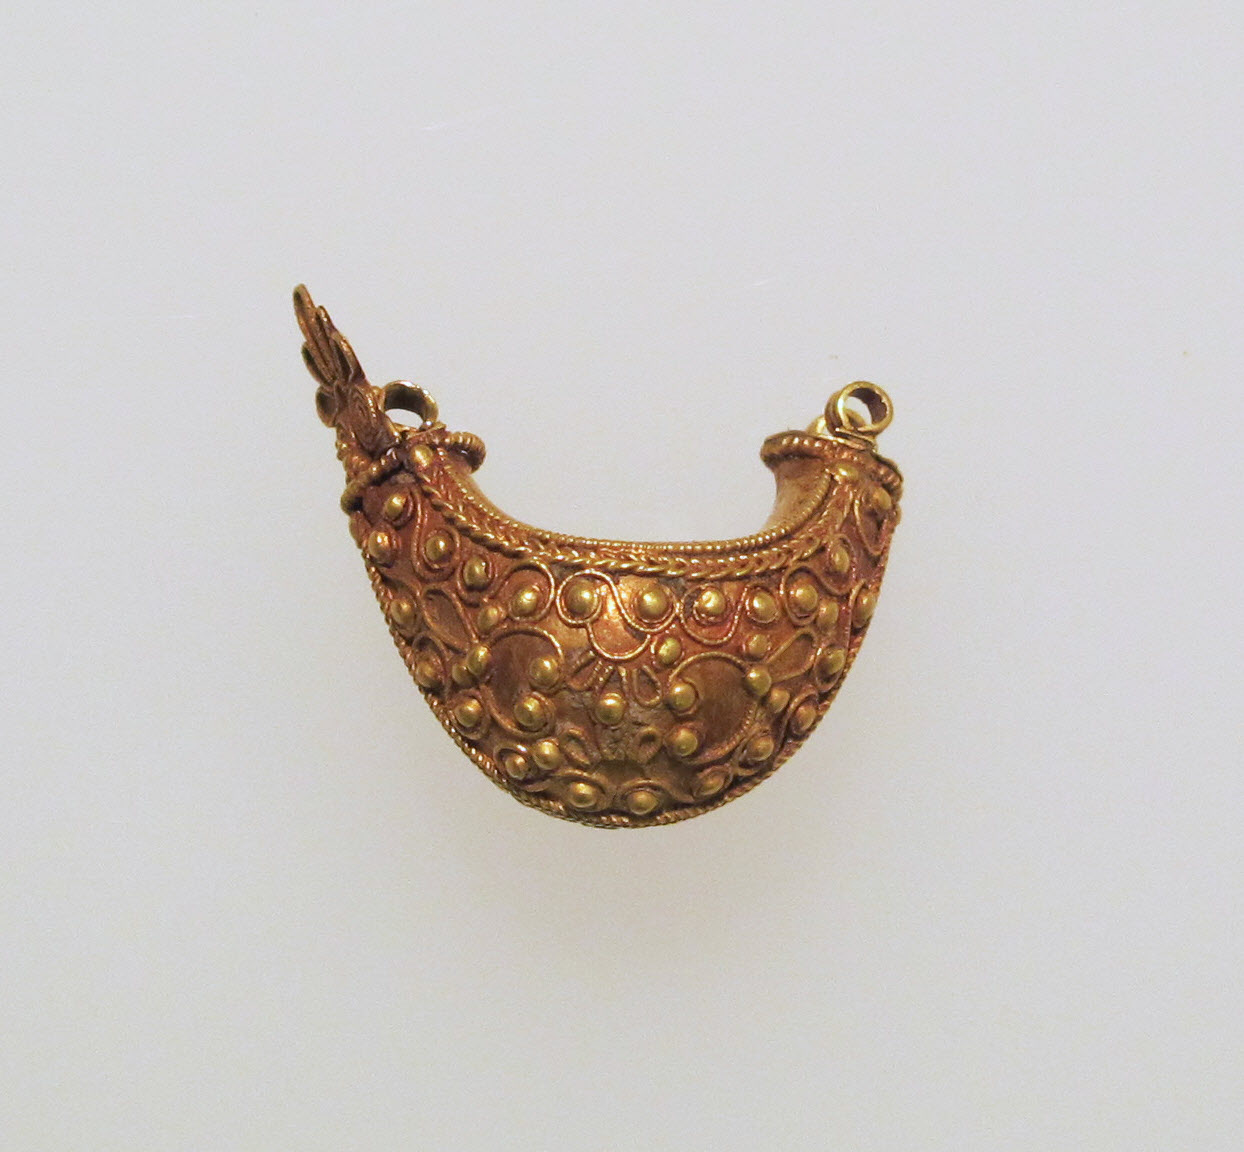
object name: earring, boat shaped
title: Earring, boat-shaped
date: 7000 BCE-330 CE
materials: gold